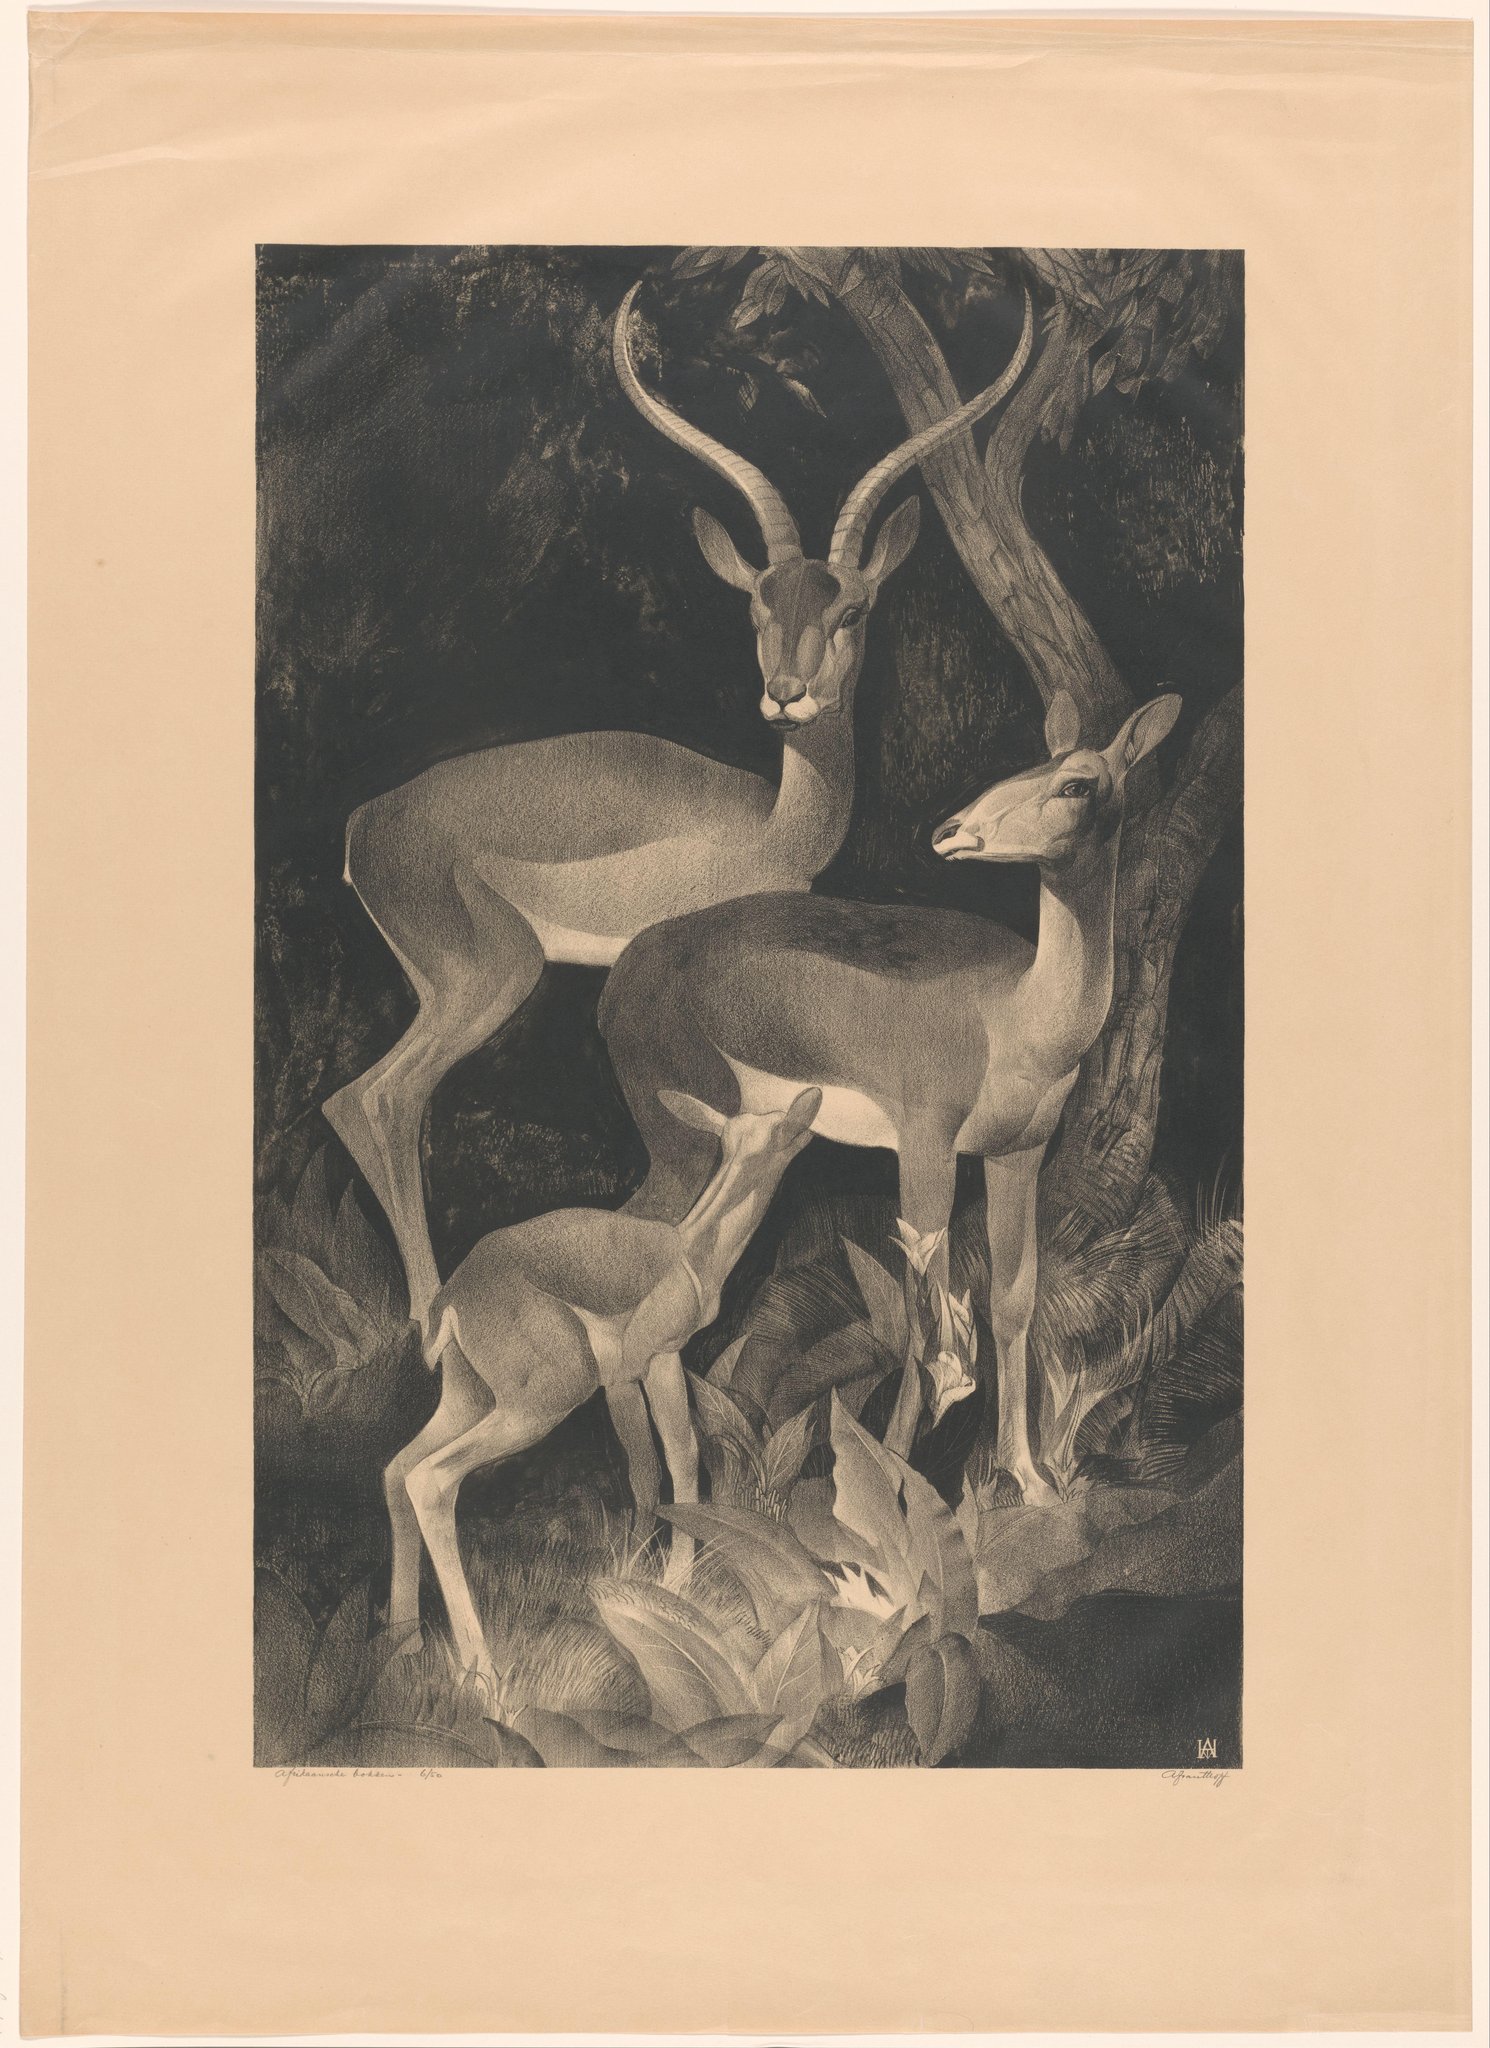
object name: print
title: Afrikaansche bokken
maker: adriaan j. van t hoff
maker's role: draughtsman, print maker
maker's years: 1893-1939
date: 1903-1932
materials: paper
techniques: lithograph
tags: hoofed animals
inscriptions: collector's mark: Lugt 2228